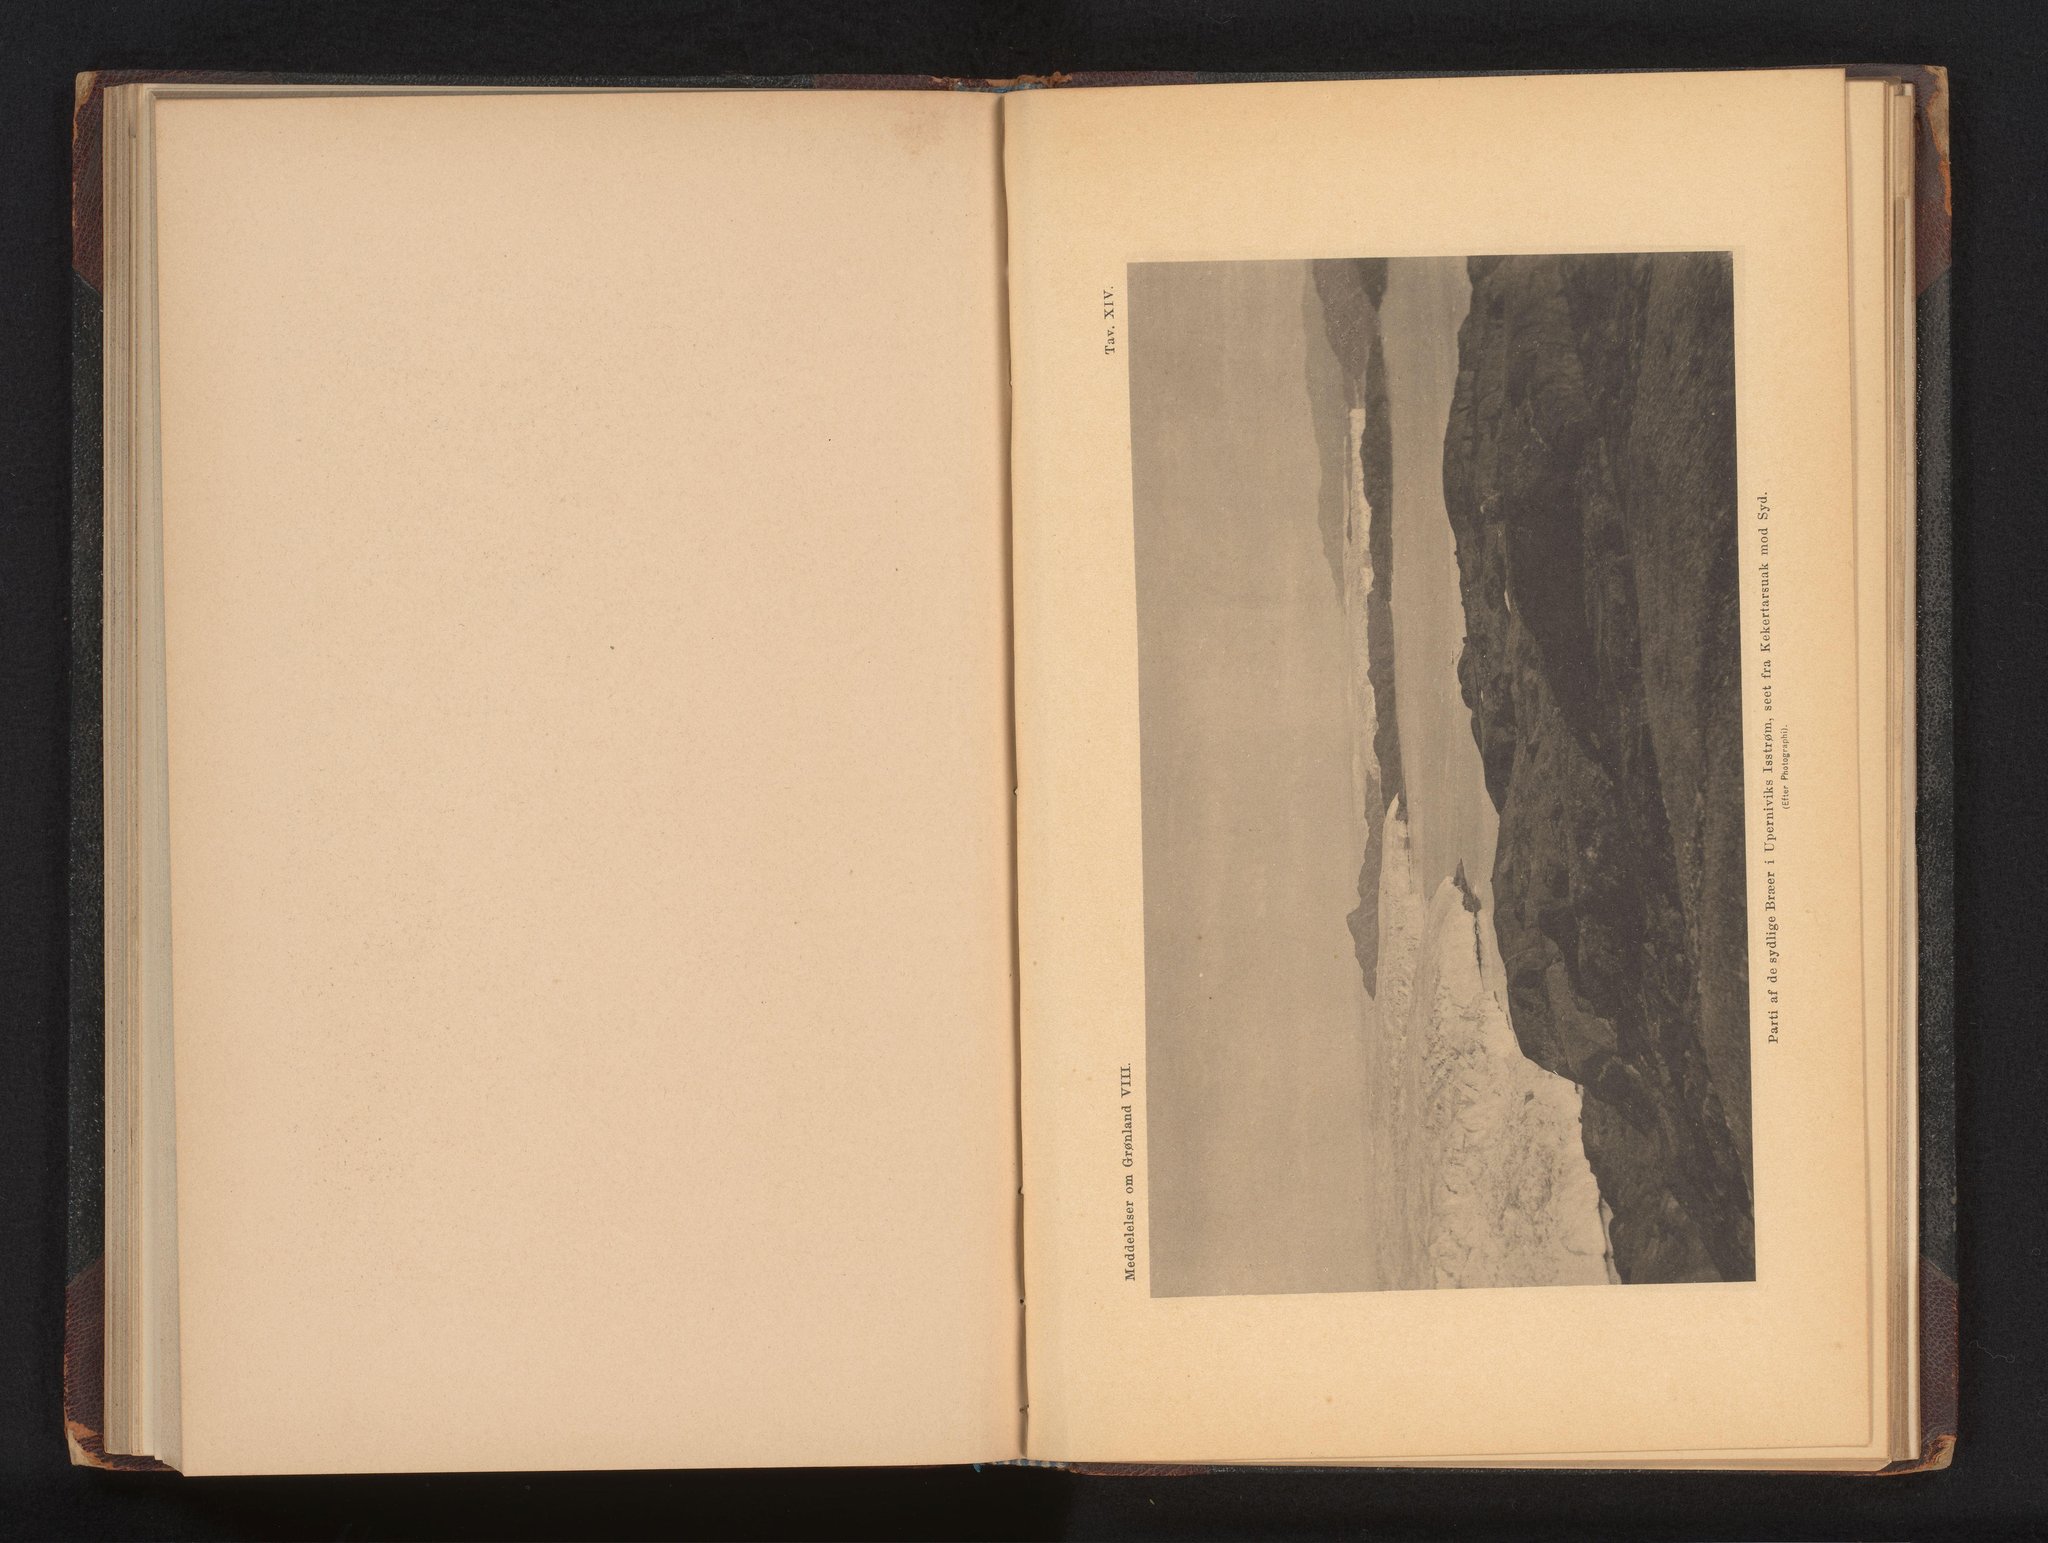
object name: page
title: Parti af de sydige Braeer i Uperniviks Isstrøm, seet fra Kekertarsuak mod Syd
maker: Anonymous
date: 1883-1888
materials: paper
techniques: photograph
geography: qeqertarsuaq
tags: glacier (in polar regions), drift ice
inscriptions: number: ‘Tav. XIV.’